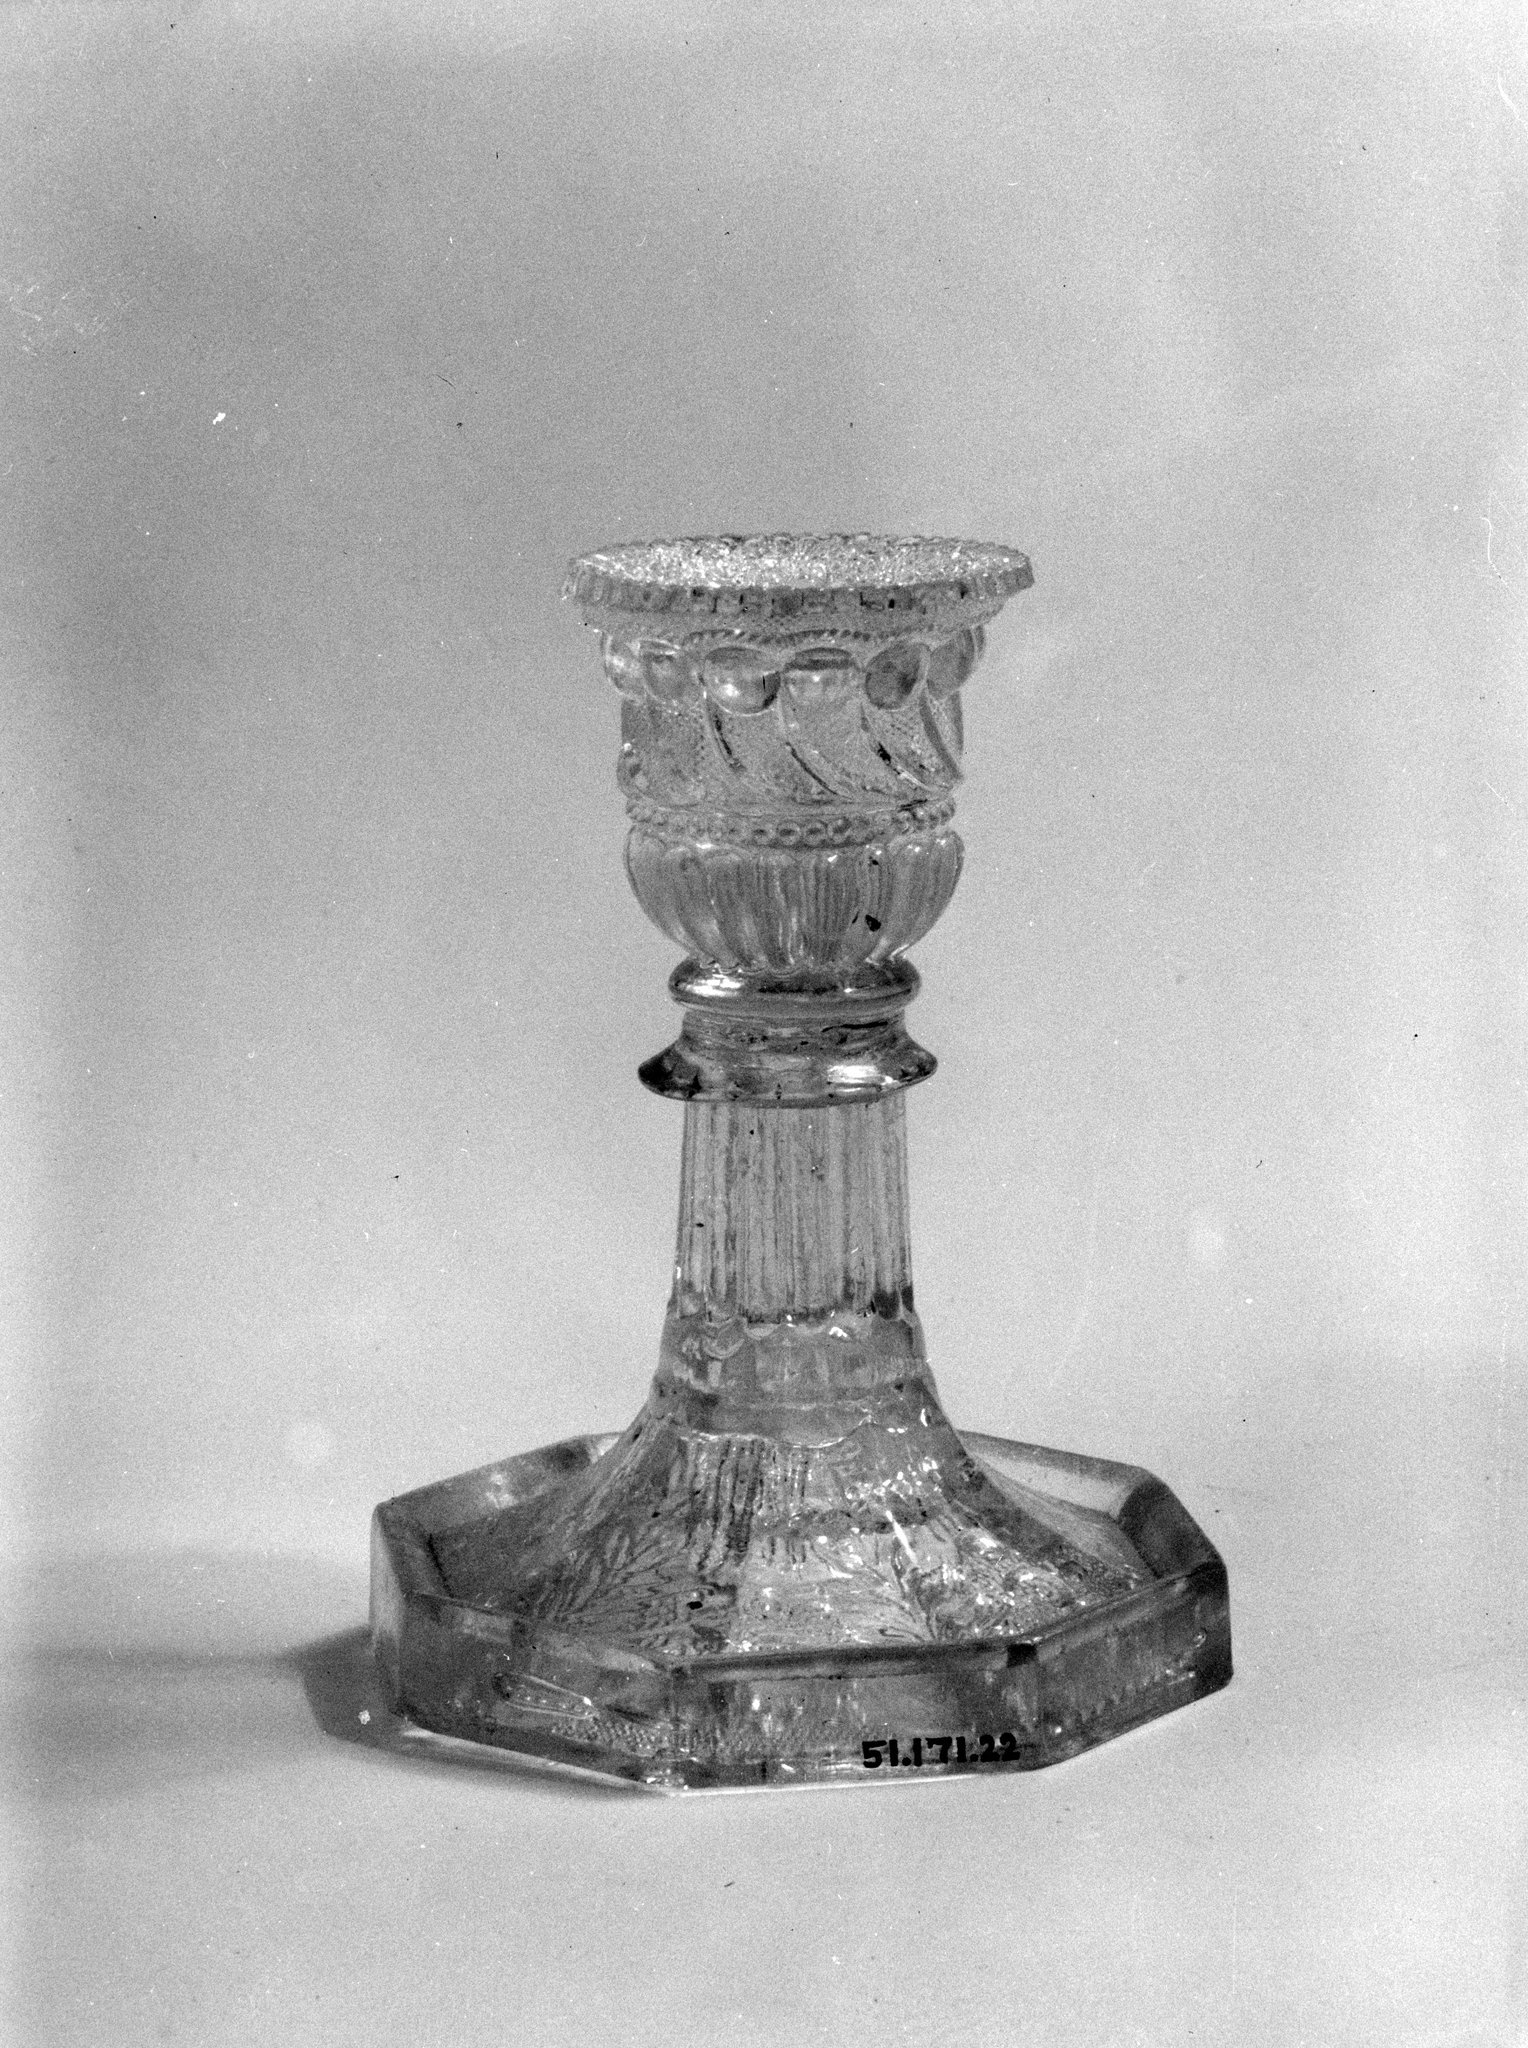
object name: candlestick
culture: american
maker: boston & sandwich glass company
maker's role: maker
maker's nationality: american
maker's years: 1825-1888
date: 1827-1835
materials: glass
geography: united states